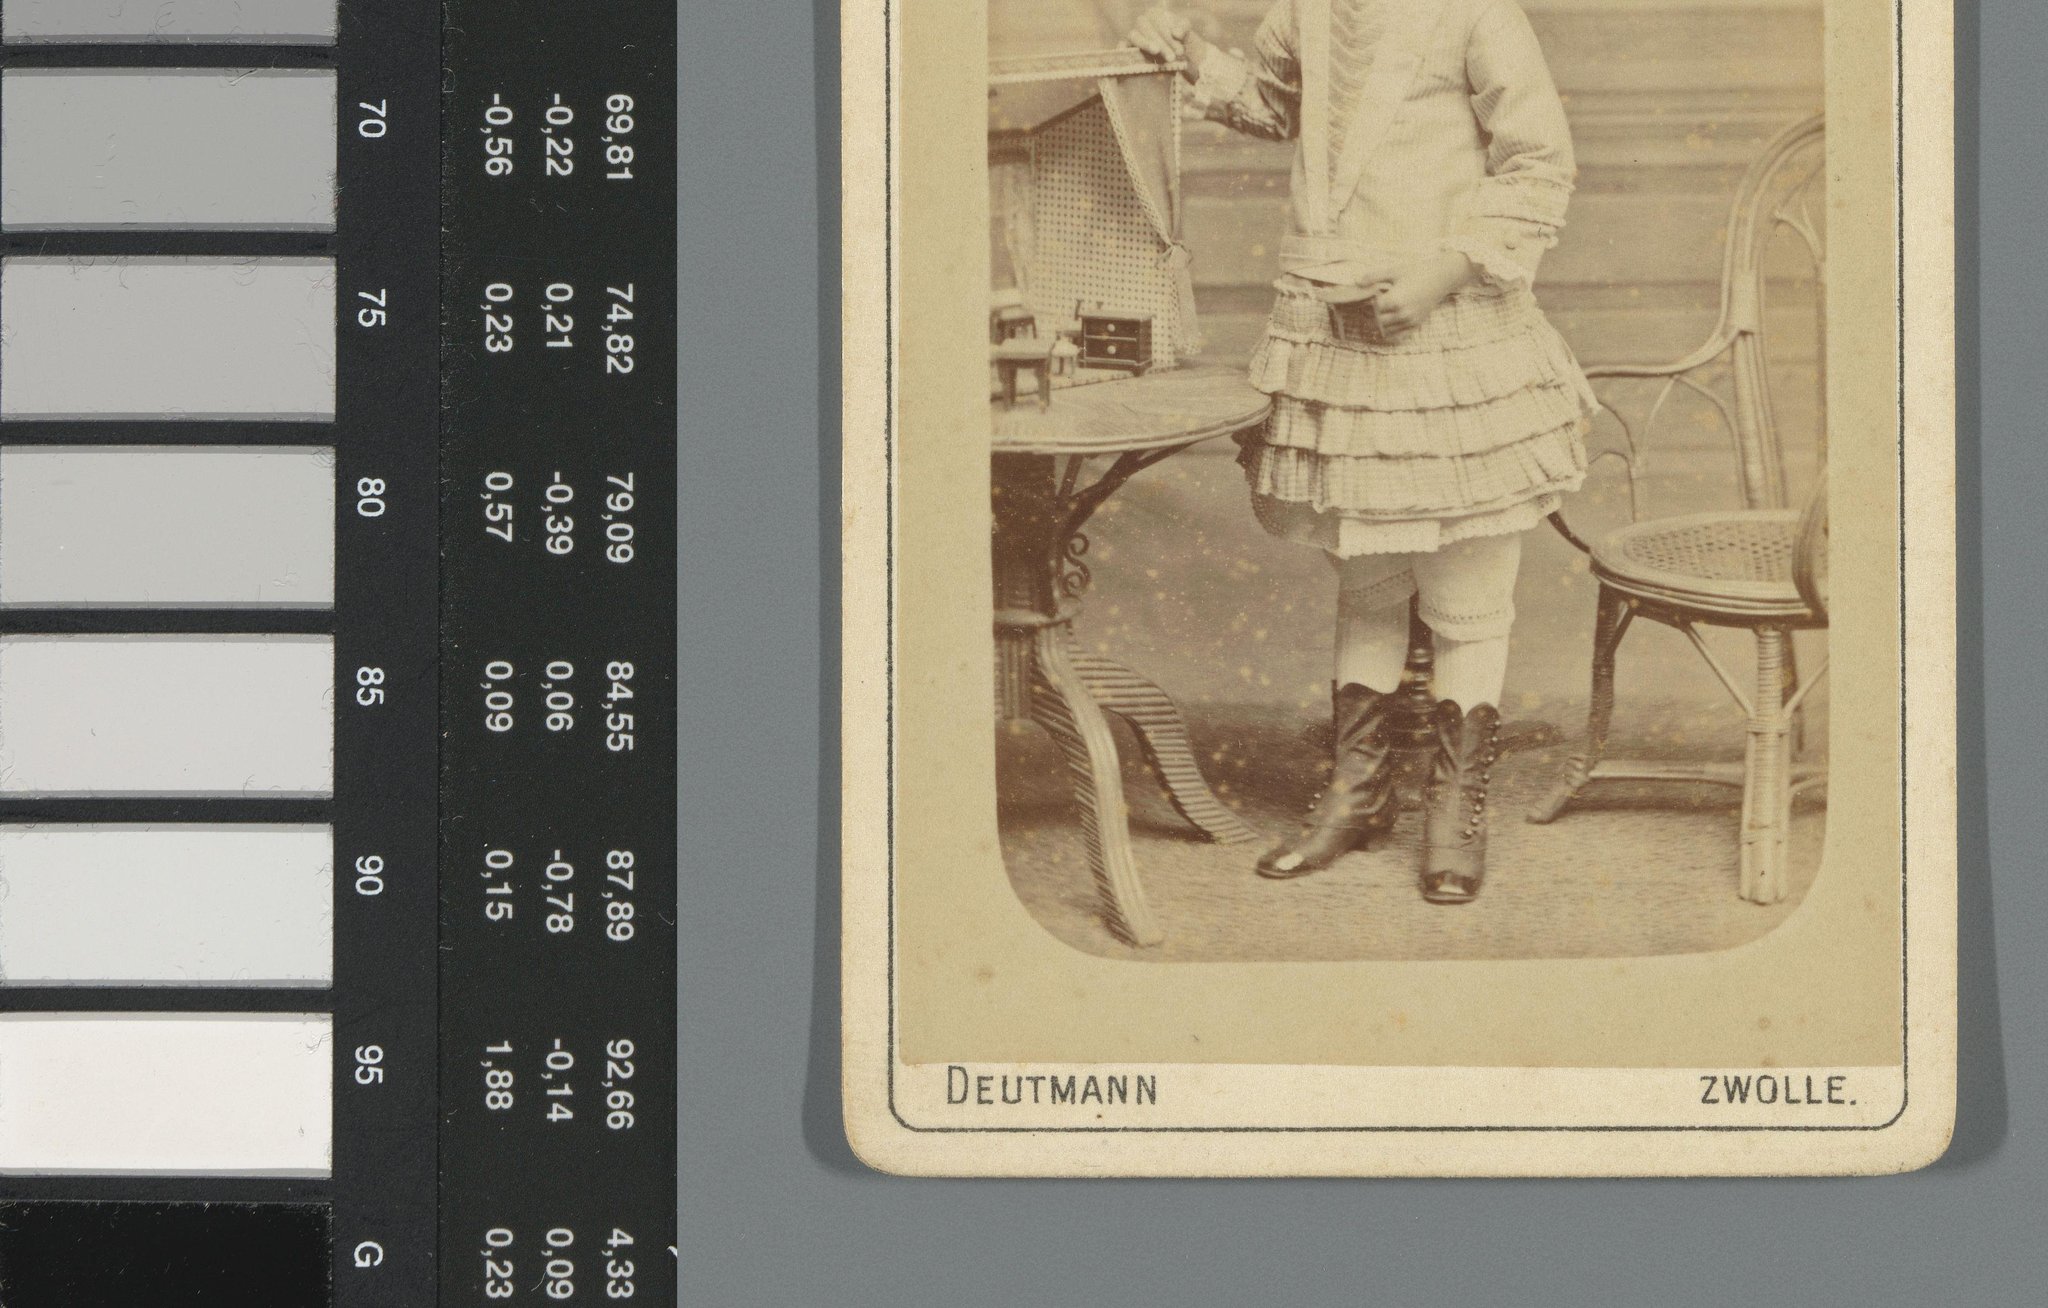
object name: photograph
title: Portret van een onbekend meisje bij poppenhuis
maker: franz wilhelm heinrich deutmann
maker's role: fotograaf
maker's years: 1840-1906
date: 1890-1895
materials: photographic support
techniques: albumen print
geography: zwolle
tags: historical persons not known by name - bb - woman, girl (child between toddler and youth), toy house, doll's house, netherlands